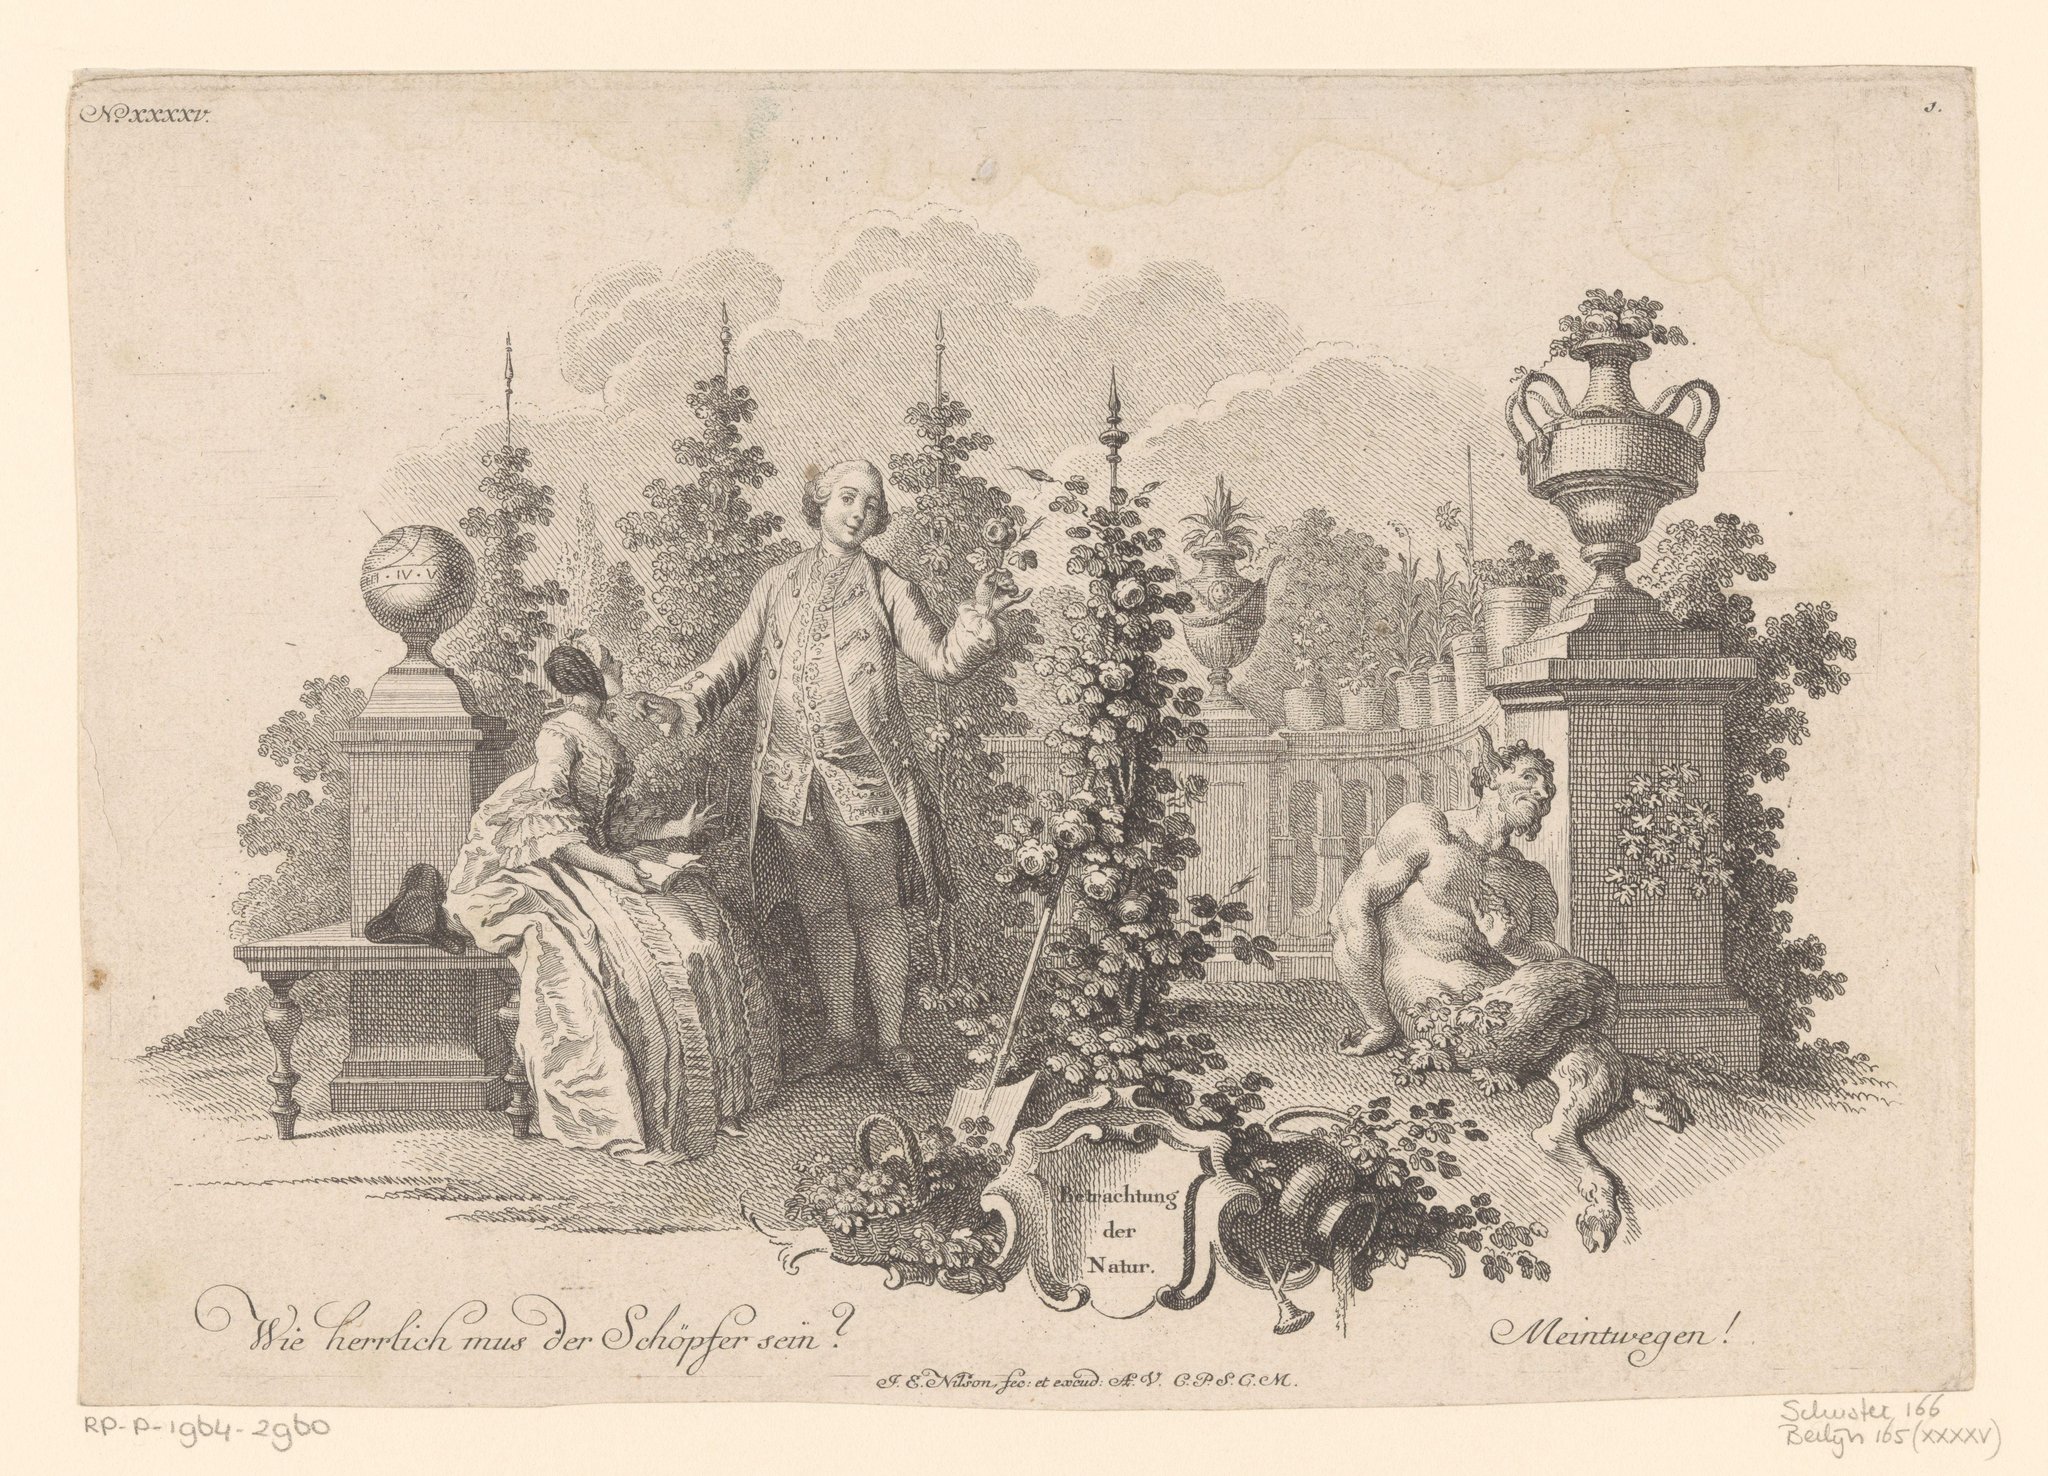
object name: ornament print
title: Beschouwing van de natuur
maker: johann esaias nilson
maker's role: draughtsman, print maker, publisher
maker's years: 1721-1788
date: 1731-1788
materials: paper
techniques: etching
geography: augsburg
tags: enjoying nature, satyr(s) (in general), couple of lovers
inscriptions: collector's mark: Lugt 2228, collector's mark: Lugt 2760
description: Een vrouw met opengeslagen boek zit in een rozentuin, naast haar staat een man met een roos in zijn hand. Het paar geniet van de schoonheid in de natuur. Rechts zit een sater op de grond, hij maakt een afwerend gebaar. Tussen de figuren in straat een rozenstruik met attributen behorende bij tuinonderhoud. In de ondermarge een Duitse tekst. Uitgeversnummer XXXXV.